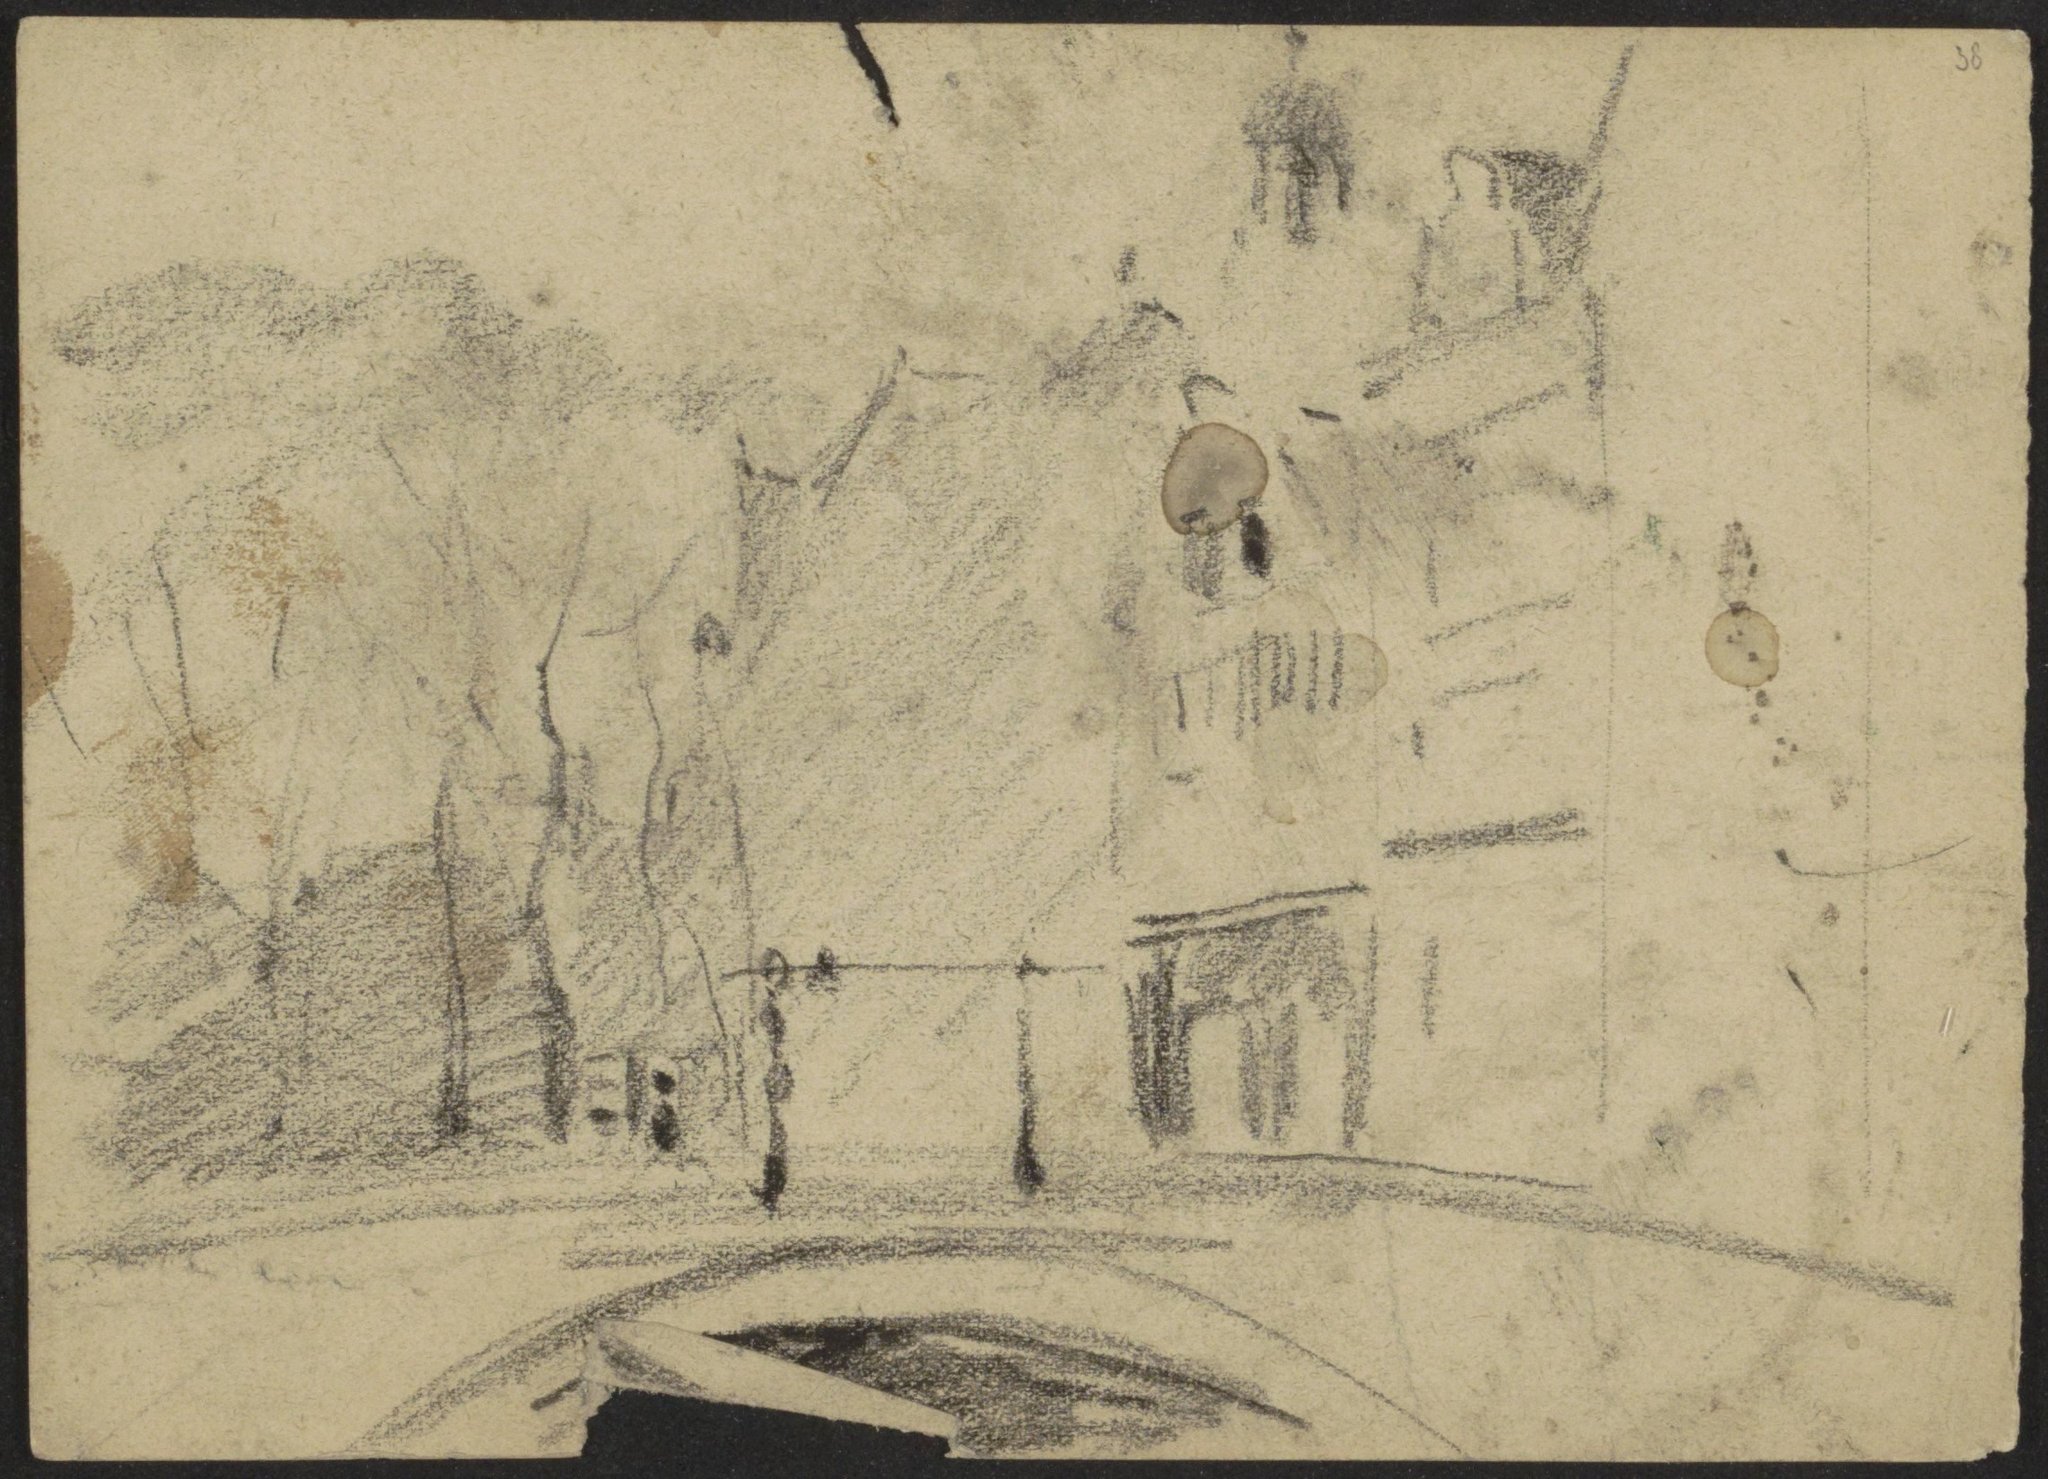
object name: sketchbook leaf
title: Gezicht op een brug in Amsterdam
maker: willem witsen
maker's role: draughtsman, painter, print maker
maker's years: 1860-1923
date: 1870-1923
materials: chalk, paper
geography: amsterdam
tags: urban housing, city-view, and landscape with man-made constructions, bridge